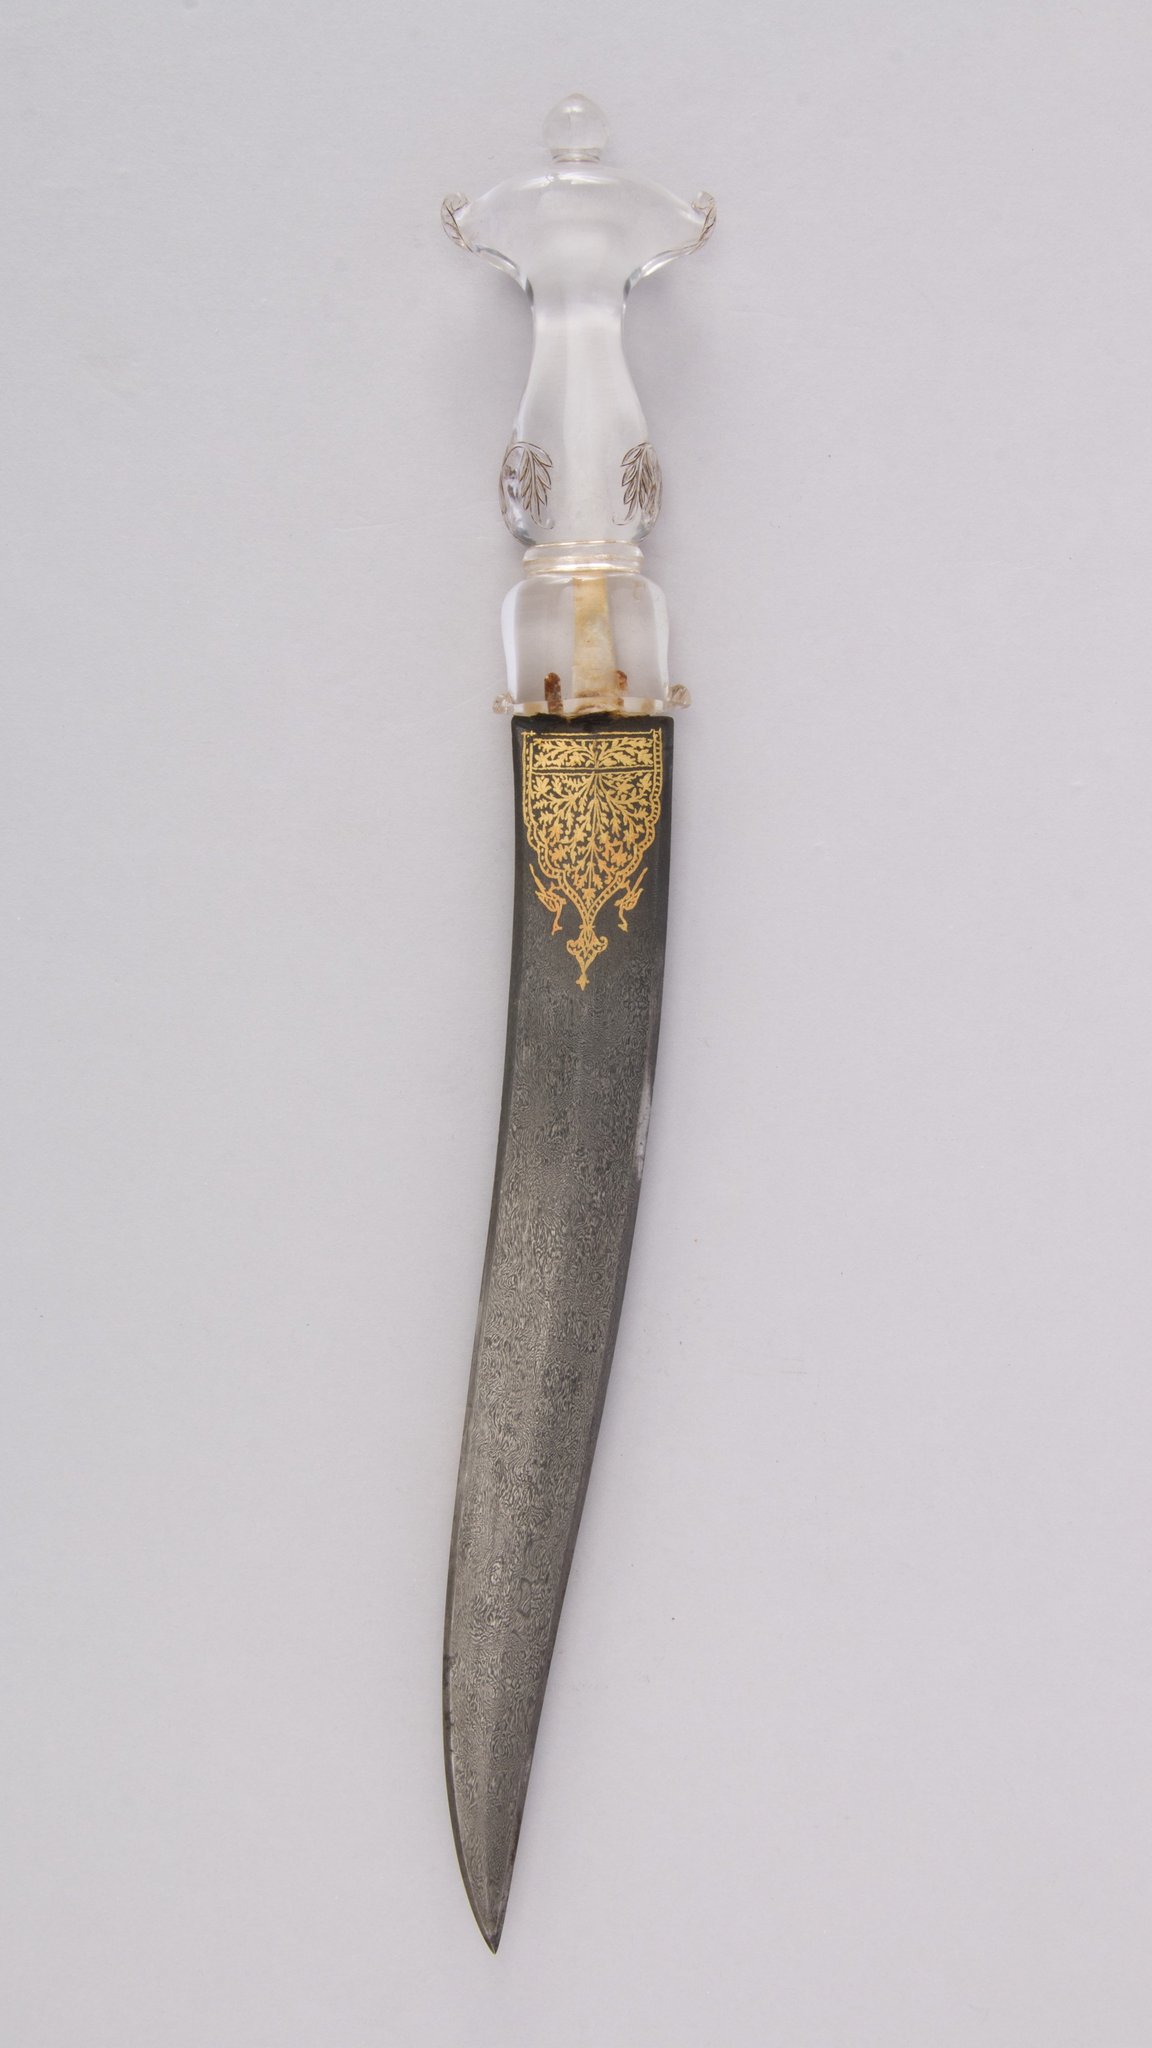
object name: dagger khanjar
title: Dagger (Khanjar)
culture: indian, deccan or mughal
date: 1701-1900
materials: gold, quartz, steel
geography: india